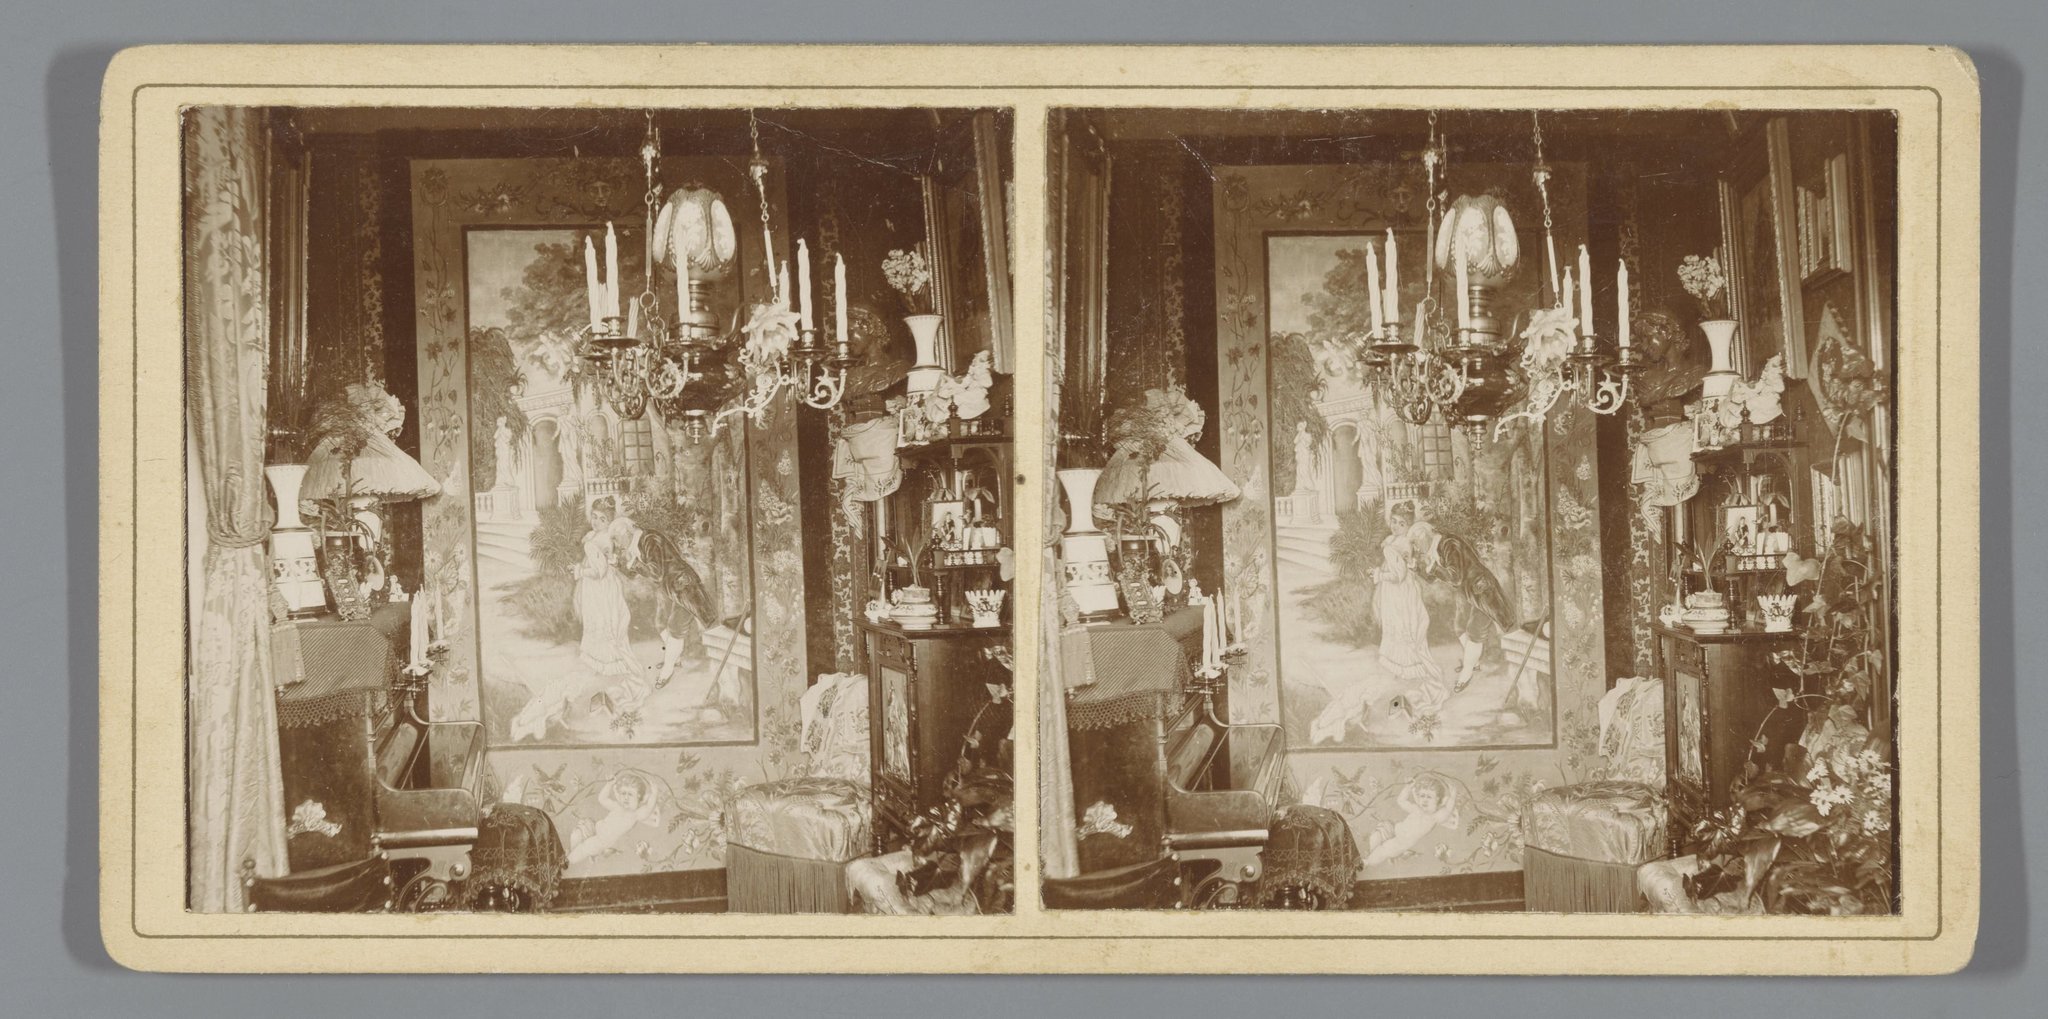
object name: stereograph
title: Interieur van een woning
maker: Anonymous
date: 1873-1890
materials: cardboard, paper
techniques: albumen print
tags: interior of the house